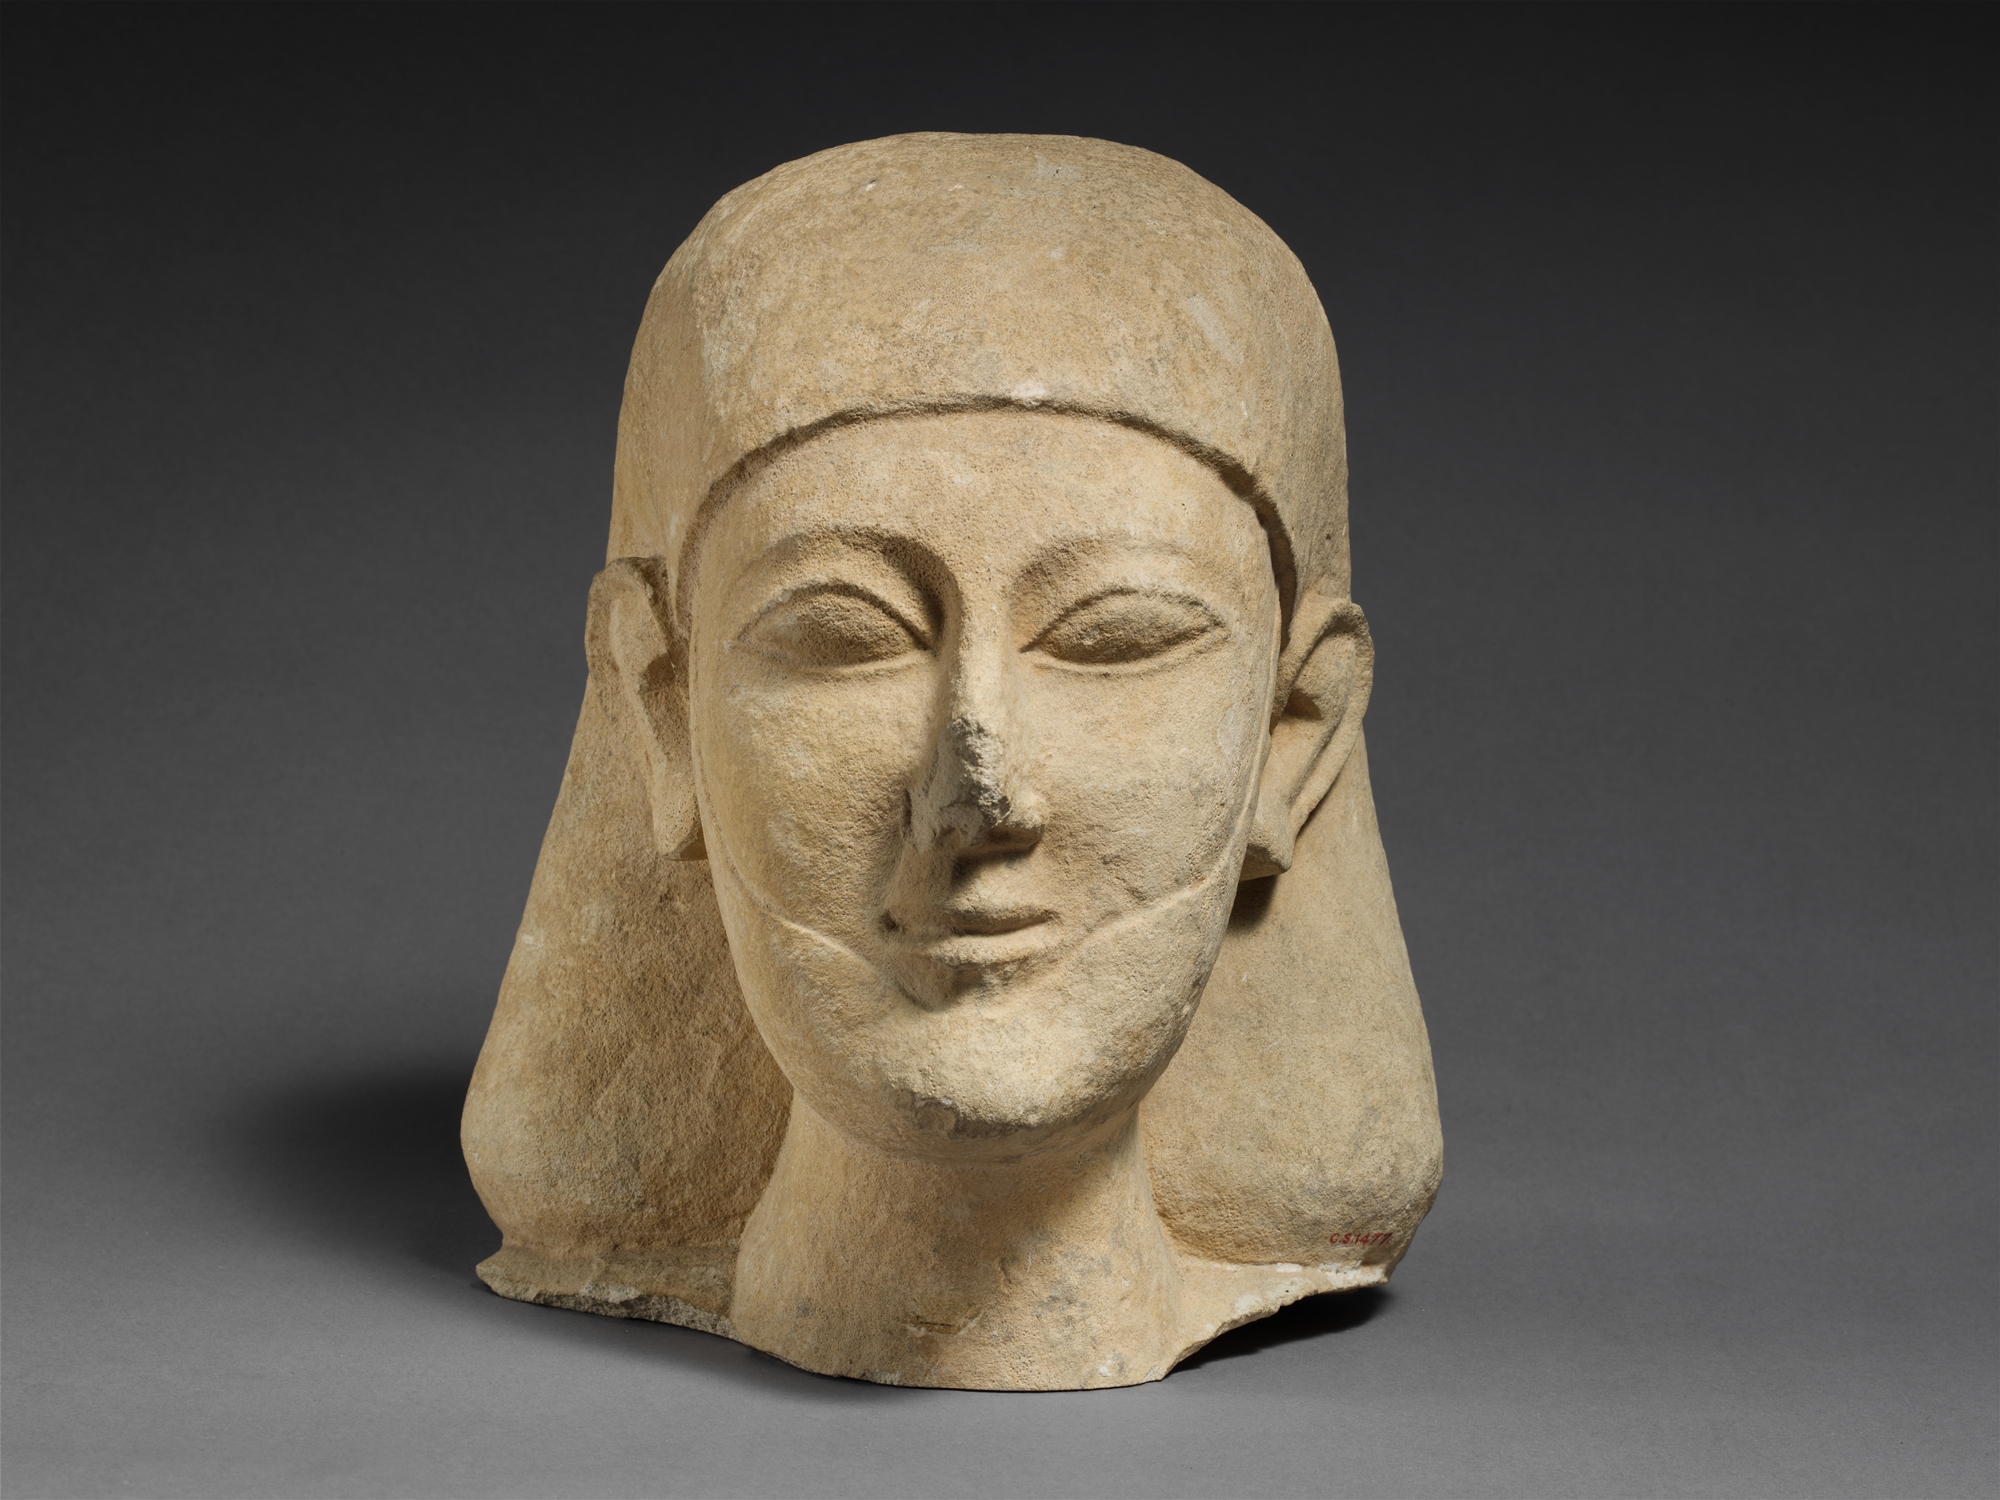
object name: head of a man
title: Limestone head of a bearded male with a plain headdress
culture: cypriot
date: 575-551 BCE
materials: limestone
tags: heads,men